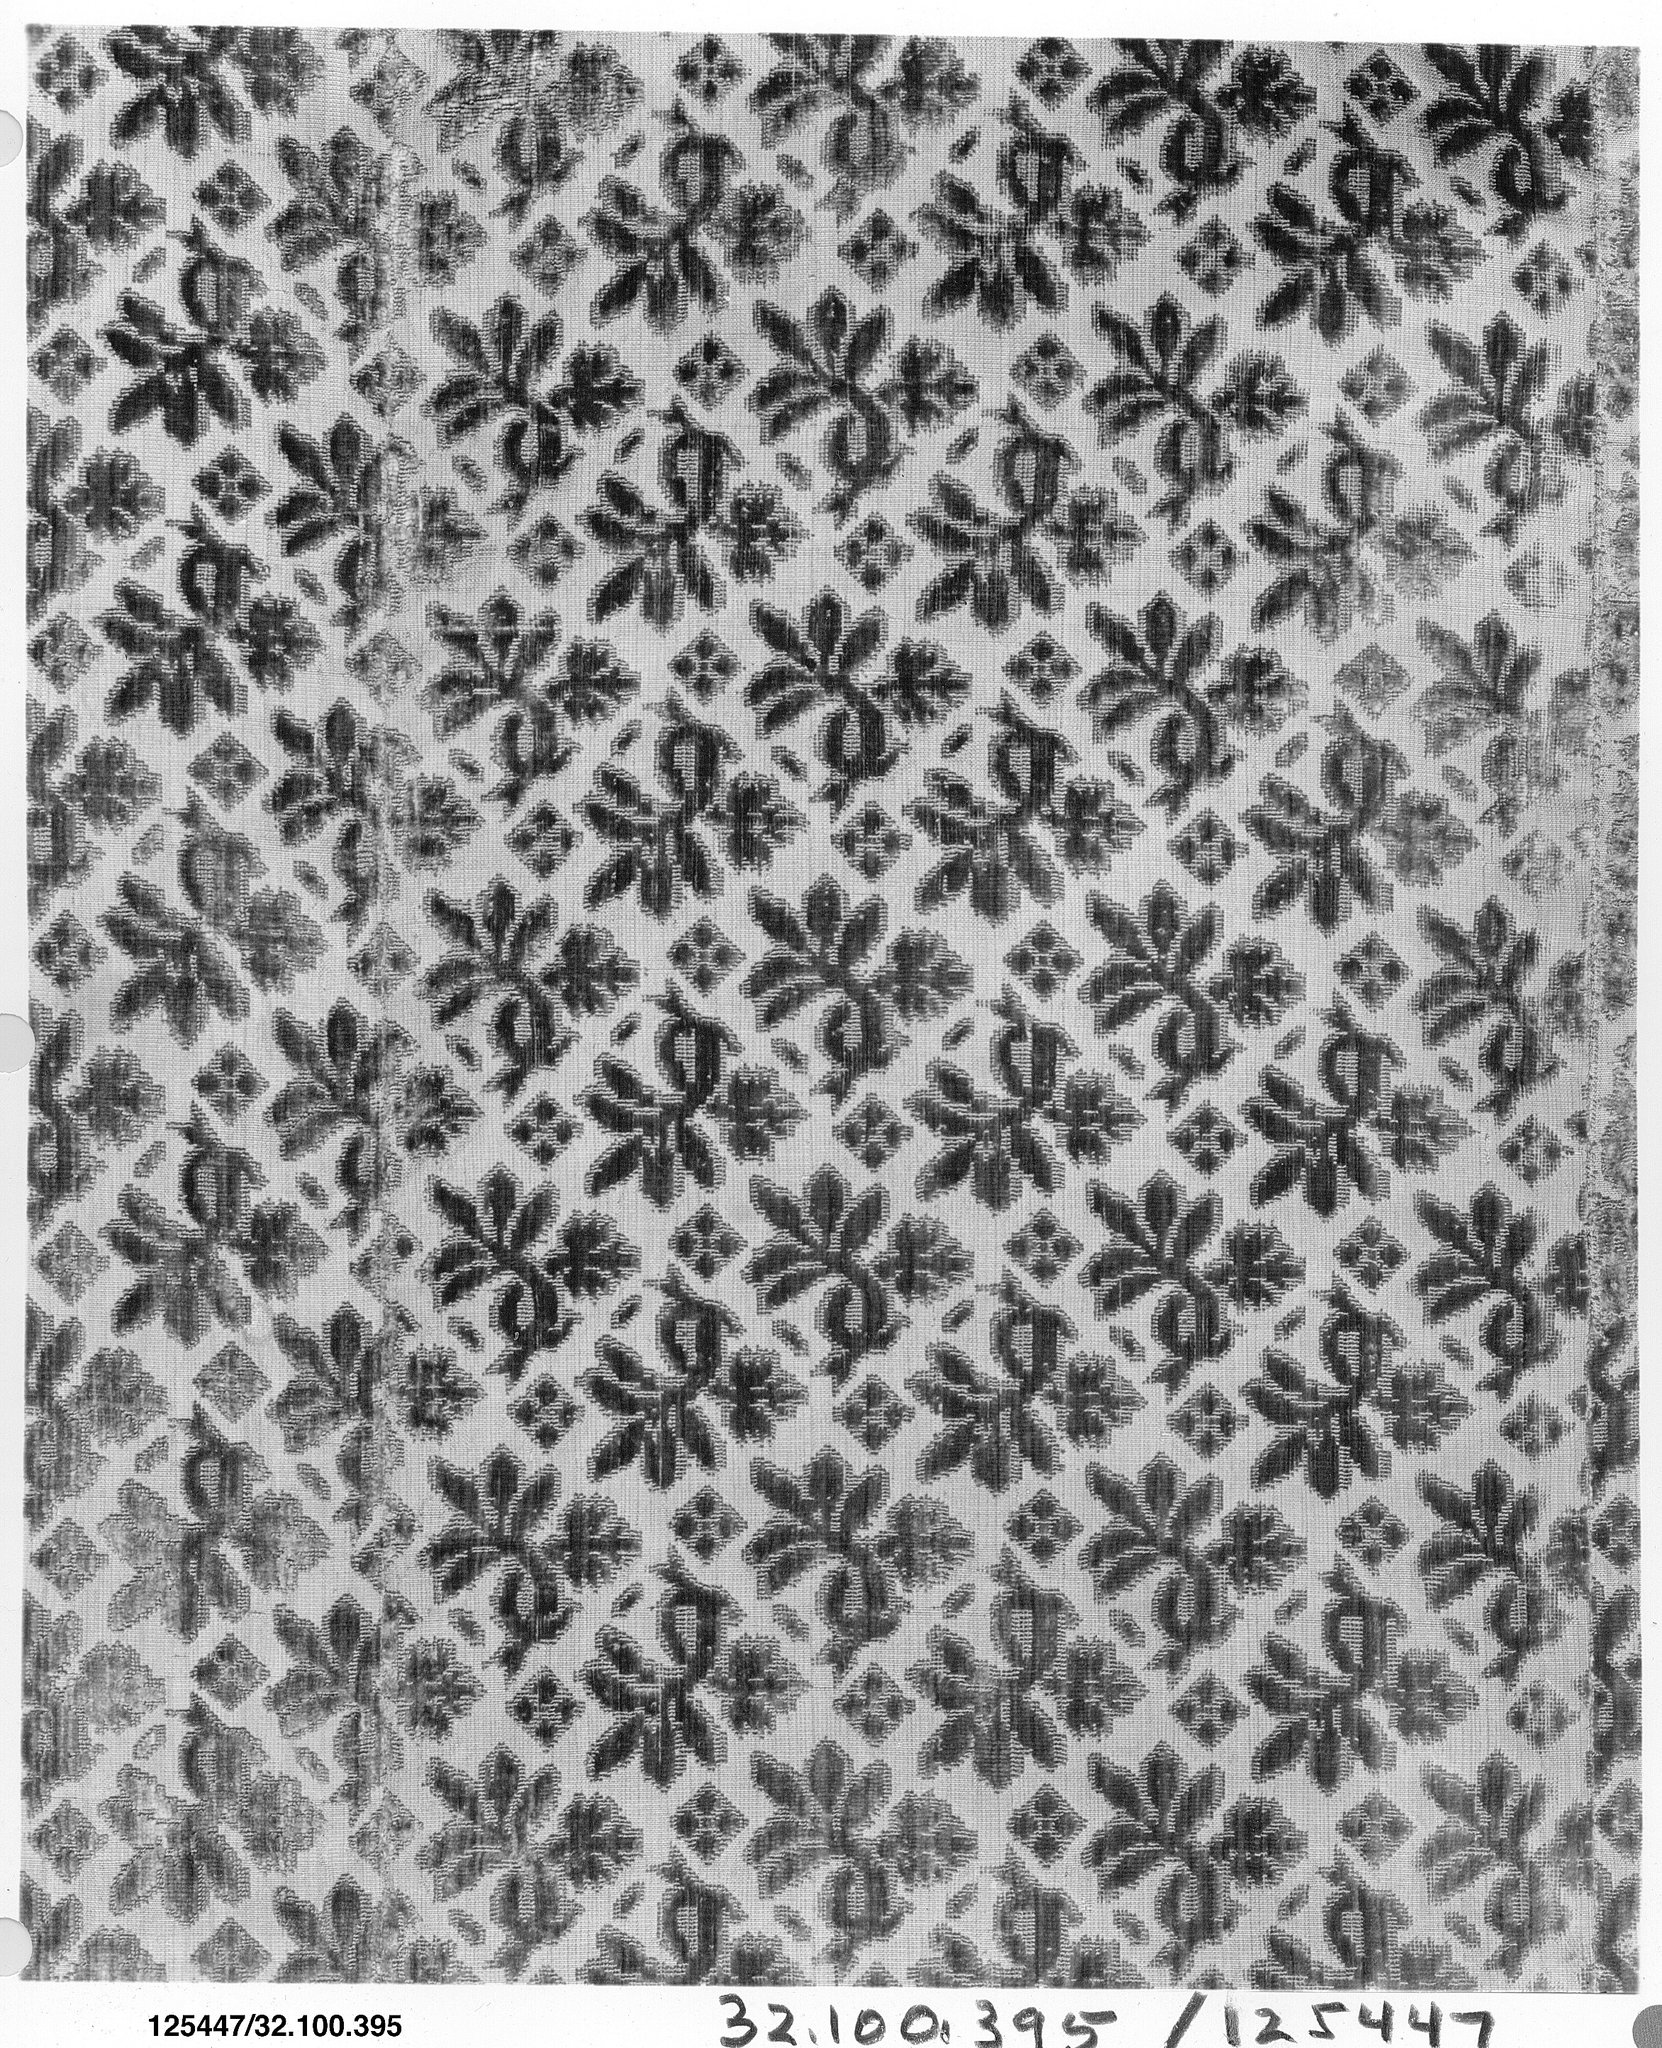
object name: panel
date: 1601-1633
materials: silk